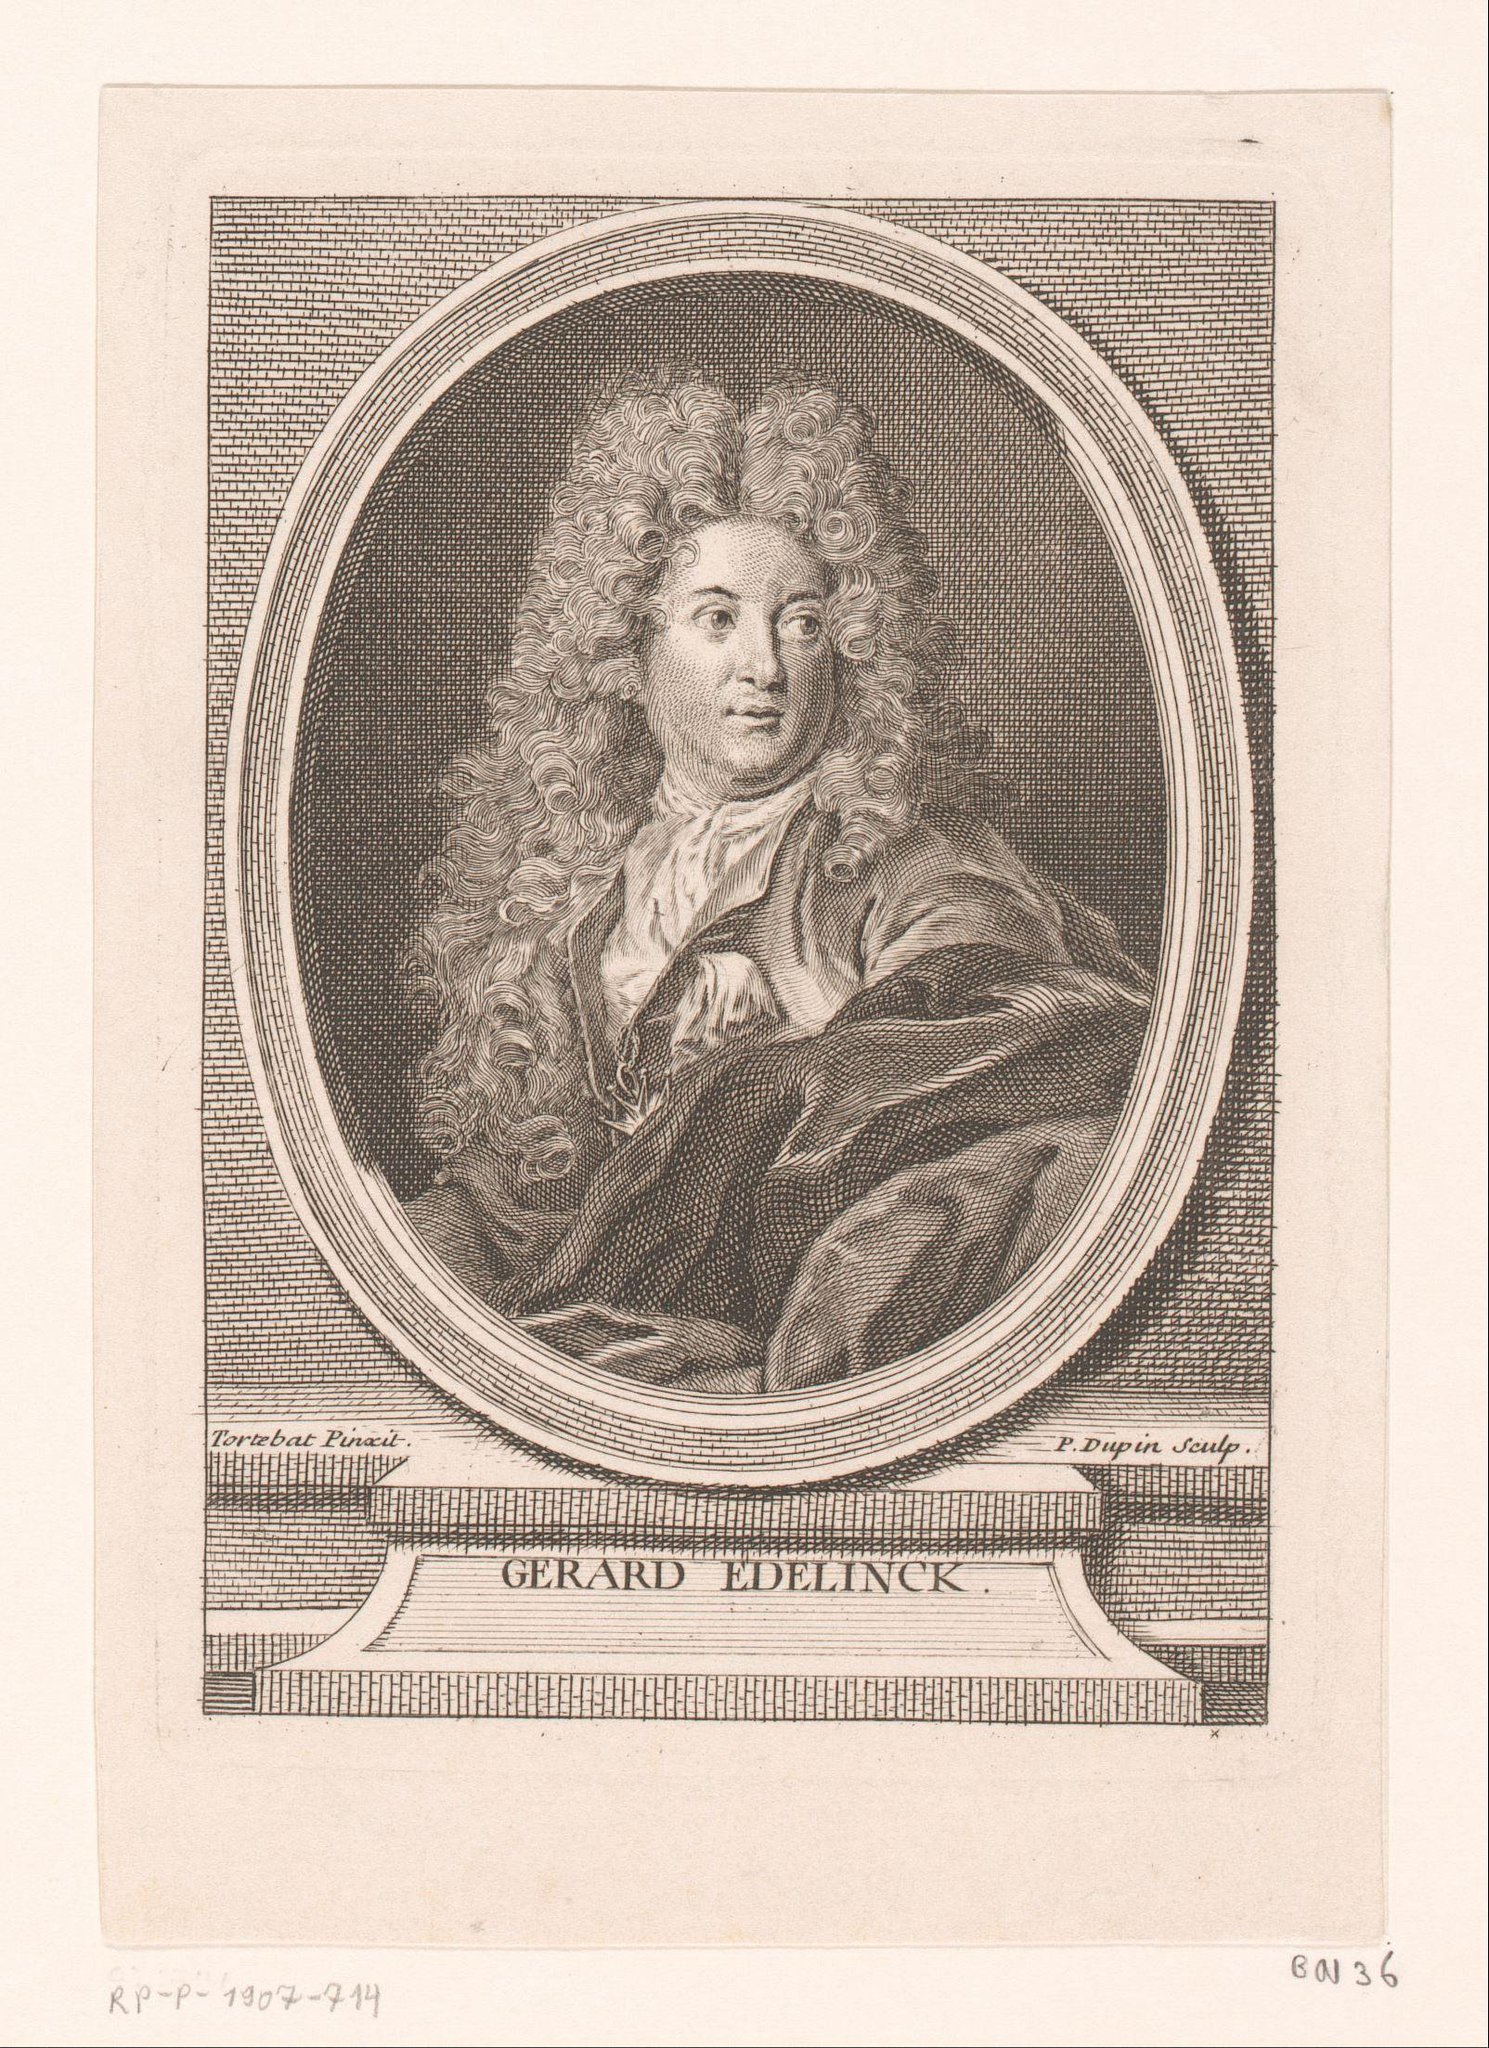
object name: print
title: Portret van Gérard Edelinck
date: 1700-1751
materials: paper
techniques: engraving, etching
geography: france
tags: antwerp, paris, print maker, gerard edelinck, ornament ~ medallion, portrait, self-portrait of graphic artist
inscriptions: collector's mark: Lugt 2228